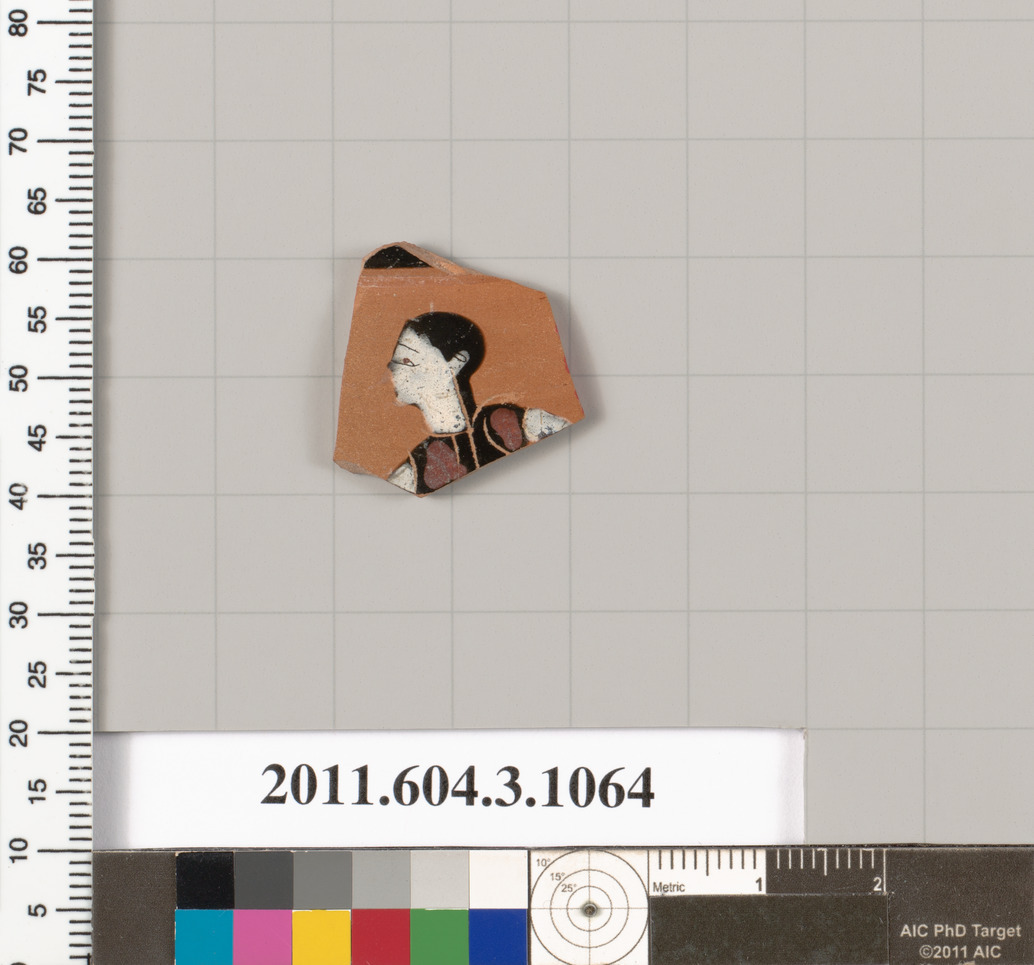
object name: mastoid fragment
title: Terracotta fragment of a mastoid (drinking cup with narrow base)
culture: greek, attic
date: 534-468 BCE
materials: terracotta